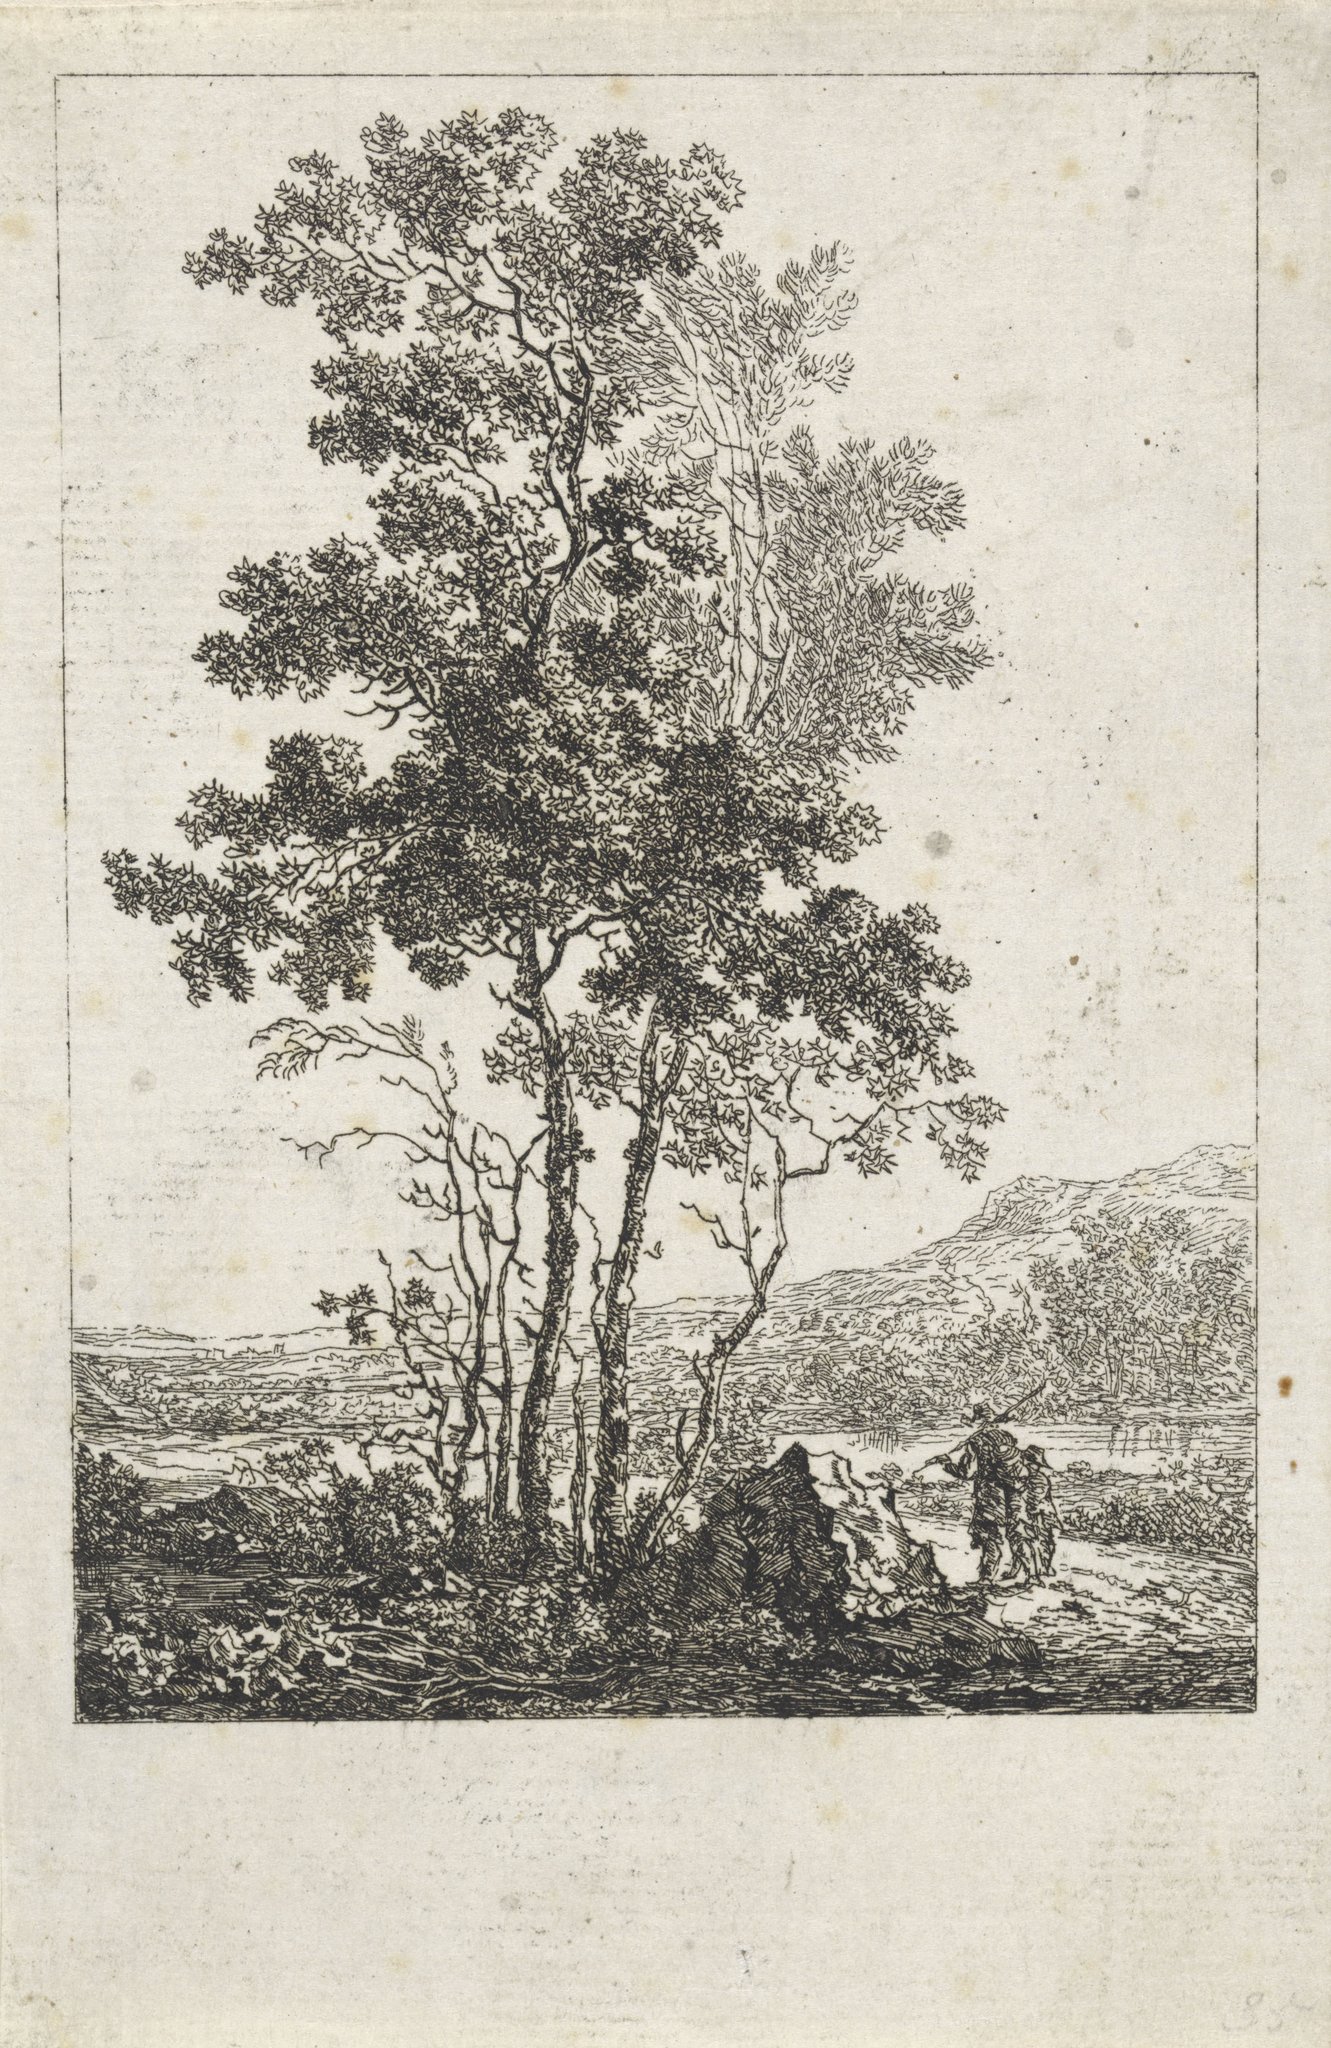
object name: print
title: Landschap met hoge bomen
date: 1766-1815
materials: paper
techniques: etching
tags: trees, landscapes in the temperate zone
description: Heuvelachtig landschap met hoge bomen en twee figuren op een weg.